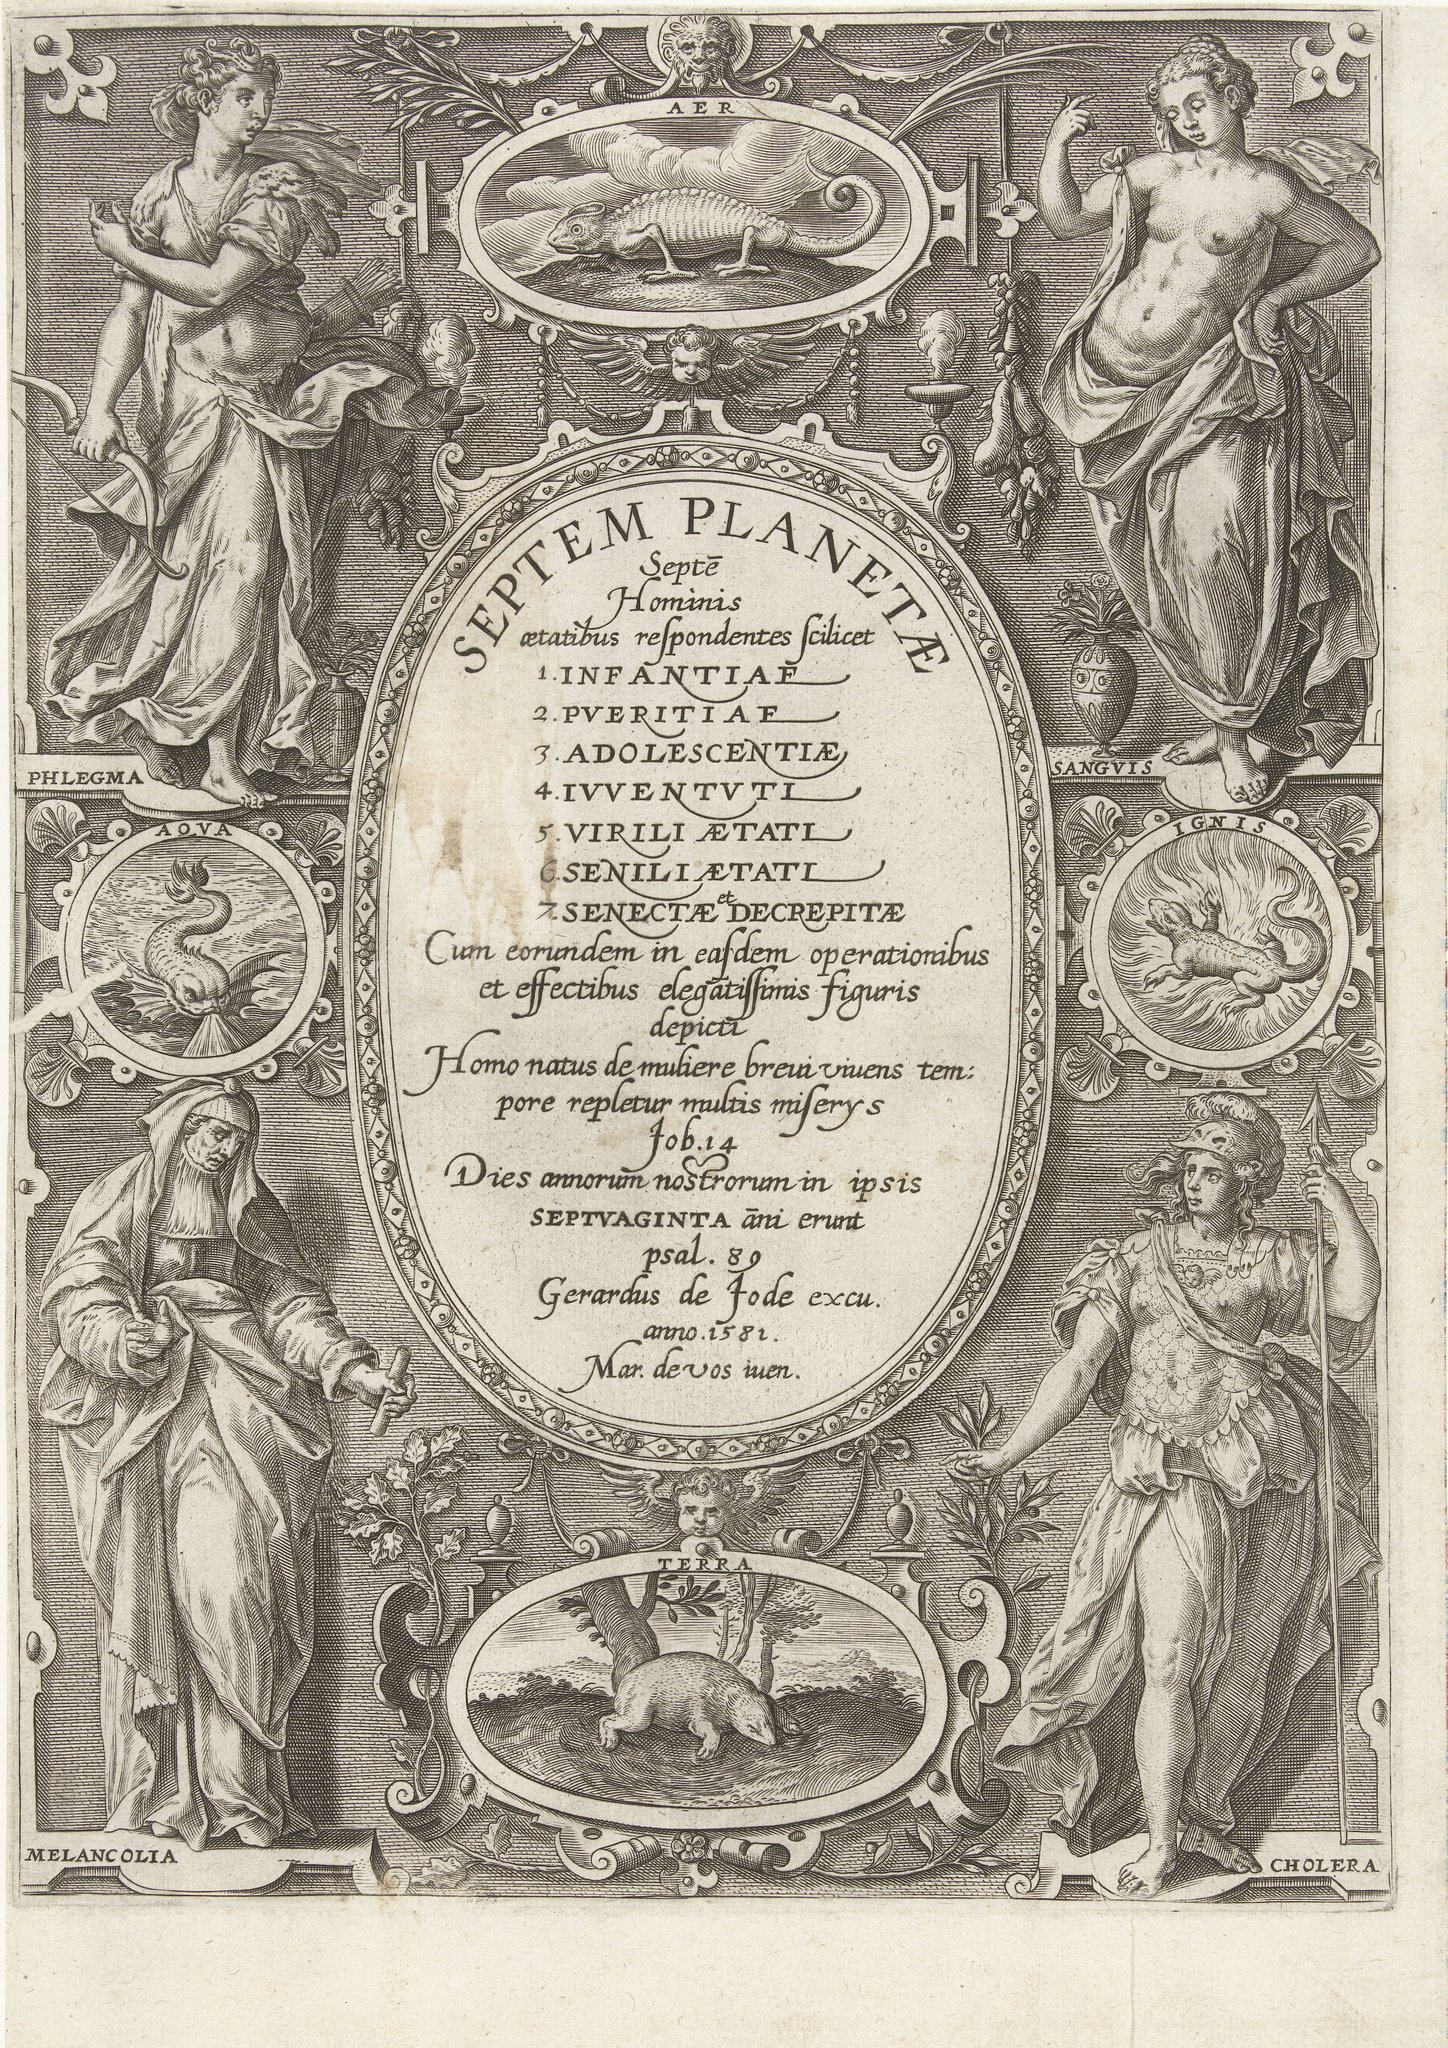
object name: print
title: De zeven planeten en de zeven leeftijden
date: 1581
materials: paper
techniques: engraving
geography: antwerp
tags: earth (one of the four elements), water (one of the four elements), fire (one of the four elements), air (one of the four elements), melancholic temperament, phlegmatic temperament, sanguine temperament, choleric temperament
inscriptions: collector's mark: Lugt 2228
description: In een ovaal de Latijnse titel, omschrijving en het adres van de uitgever. Aan weerszijden van de ovaal de vier personificaties van de vier temperamenten en de symbolen voor de vier elementen. Rechtsboven Venus als Sanguis, linksboven Diana als Phlegma, linksonder een oudere non als Melancolia en rechtsonder Minerva als Cholera. Tussen deze allegorische figuren vier cartouches met de symbolische dieren van de vier elementen: de kameleon staat voor lucht, de dolfijn voor water, de mol voor aarde en de salamander voor vuur. De prent is de titelprent van een serie over de macht van de zeven planeten over de zeven leeftijden van de mens.